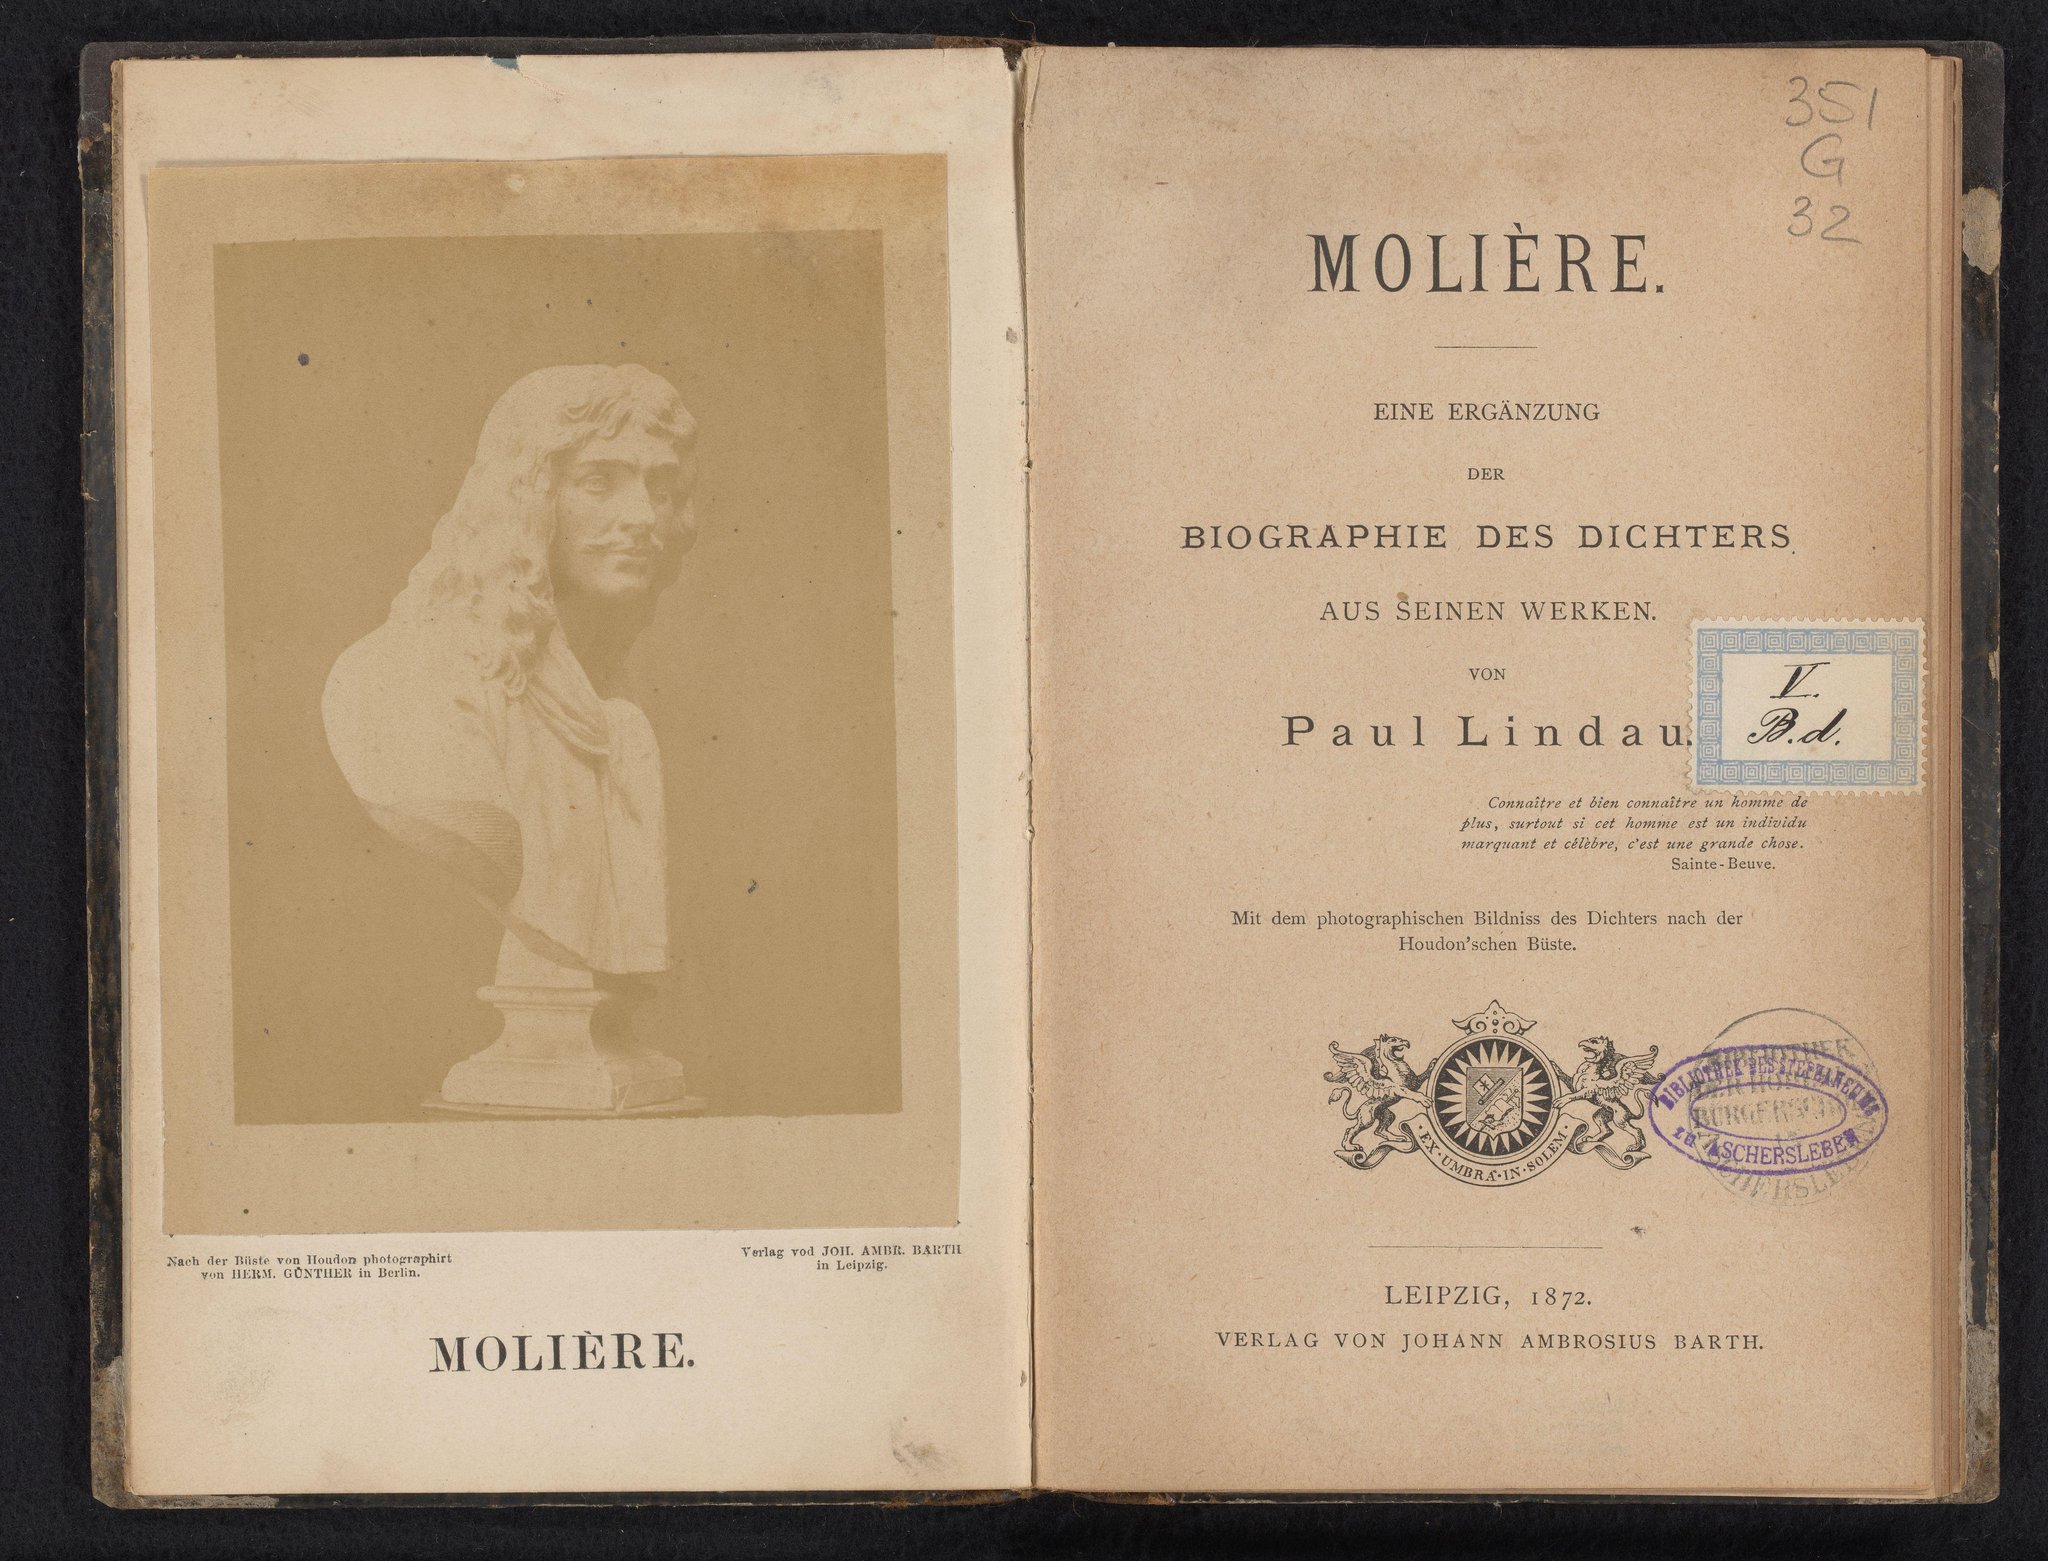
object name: book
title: Molière : eine Ergänzung der Biographie des Dichters aus seinen Werken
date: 1872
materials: cardboard, leather, paper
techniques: albumen print, letterpress printing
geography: leipzig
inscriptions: inscription: ‘Laufende/ Nr. 4805’, collector's mark: ‘BIBLIOTHEEK/ RIJKSMUSEUM/ AMSTERDAM’, inscription: ‘V/ B.d.’, collector's mark: ‘BIBLIOTHEK DES STEPHANEUMS/ zu SCHERSLEBE’